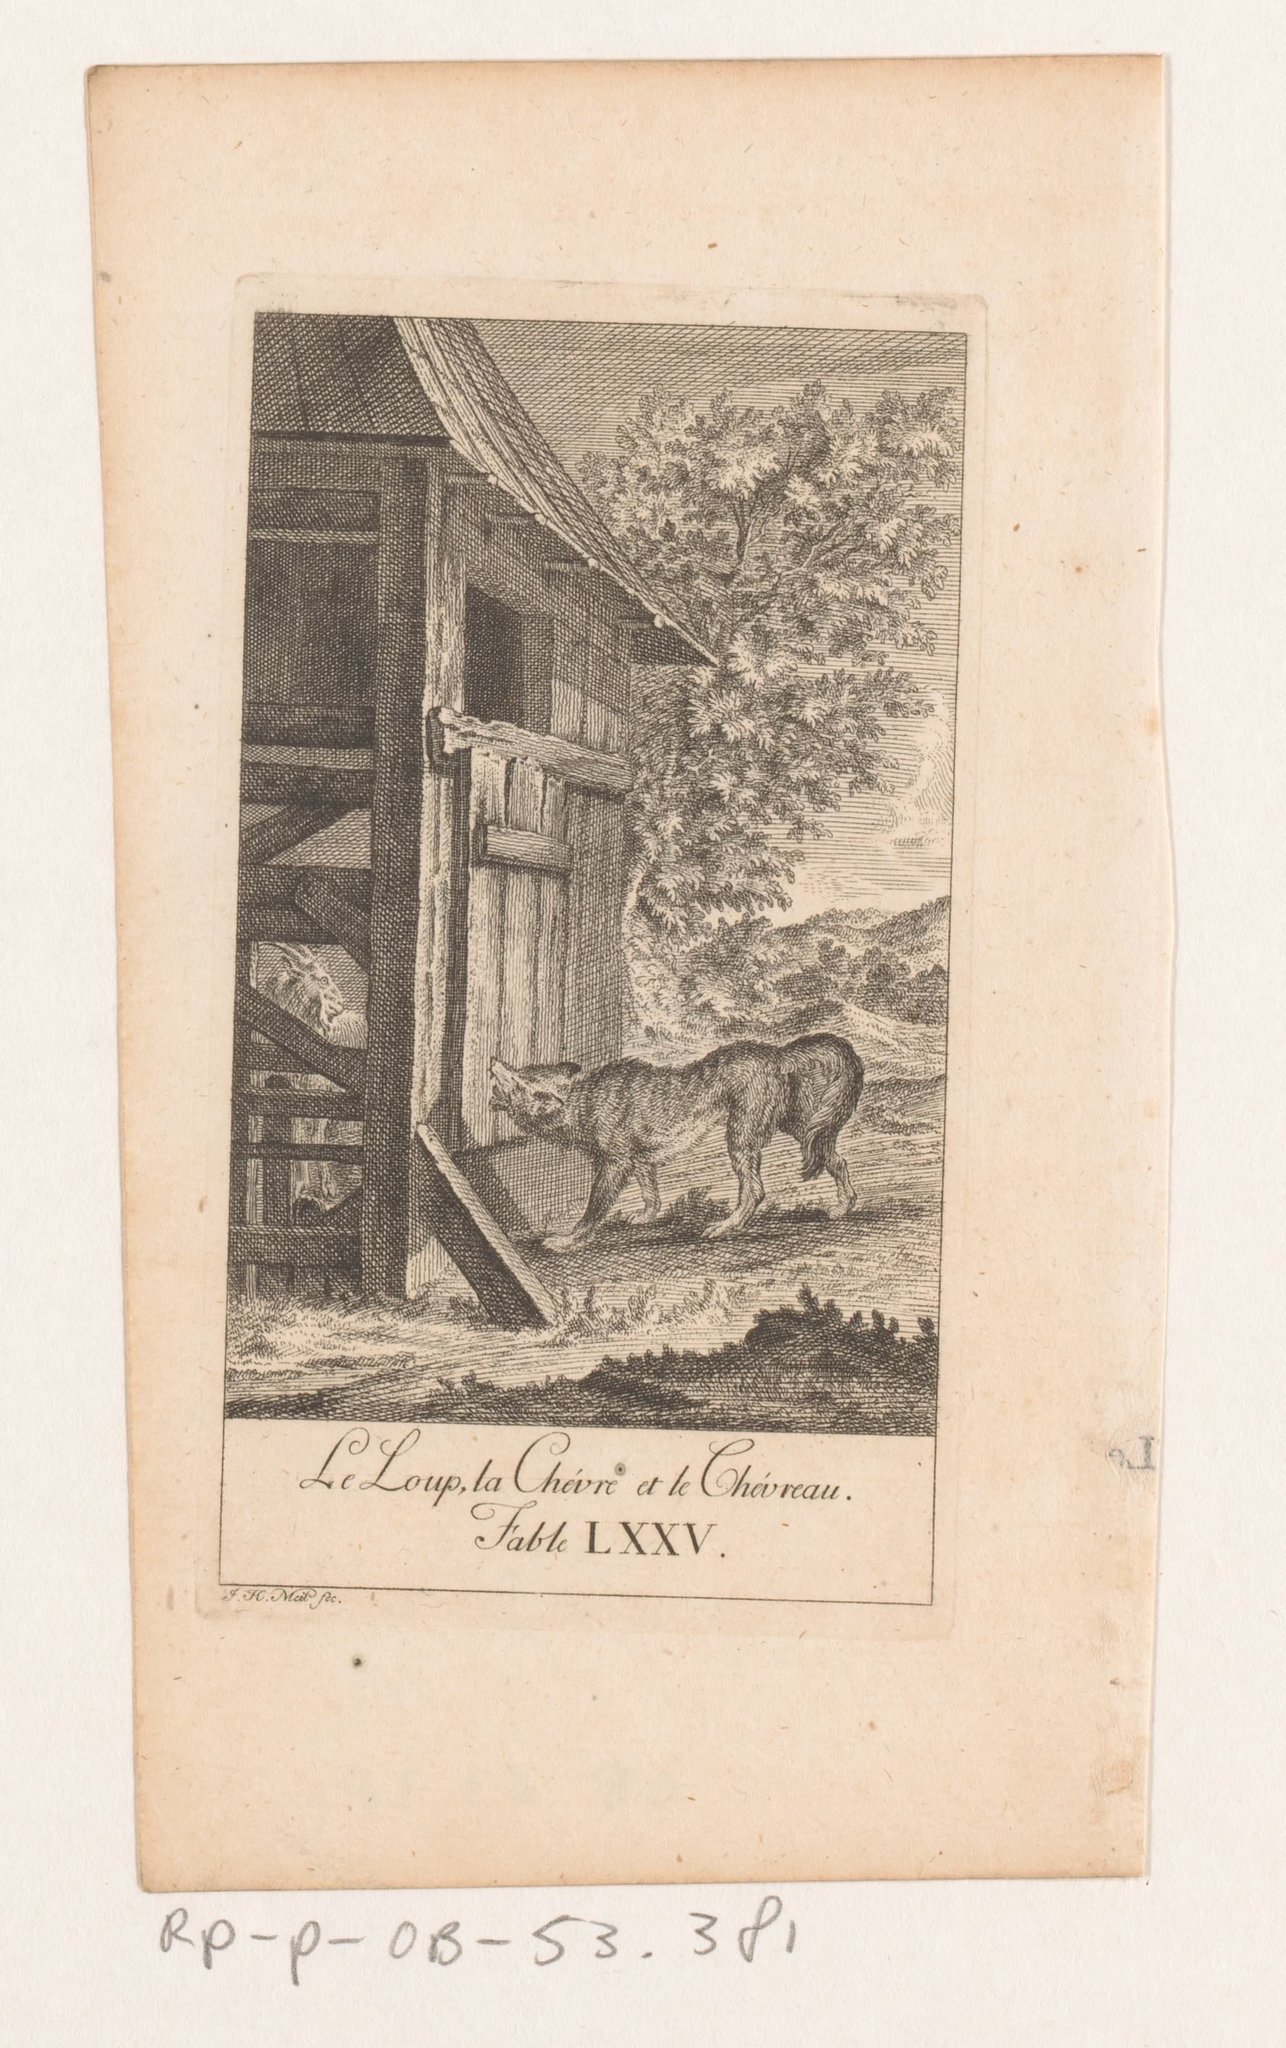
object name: print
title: Fables choisies, mises en vers par J. de la Fontaine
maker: johann heinrich meil (der ältere)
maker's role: print maker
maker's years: 1730-1820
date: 1758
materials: paper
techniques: etching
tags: fables of lafontaine : use 85(...), sheep, beasts of prey, predatory animals: wolf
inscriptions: collector's mark: Lugt 2228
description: Illustratie uit: Fontaine, J. de la. Fables choisies, mises en vers. Dl. 2. Dresden & Leipzig: George Conrad Walther, 1758.